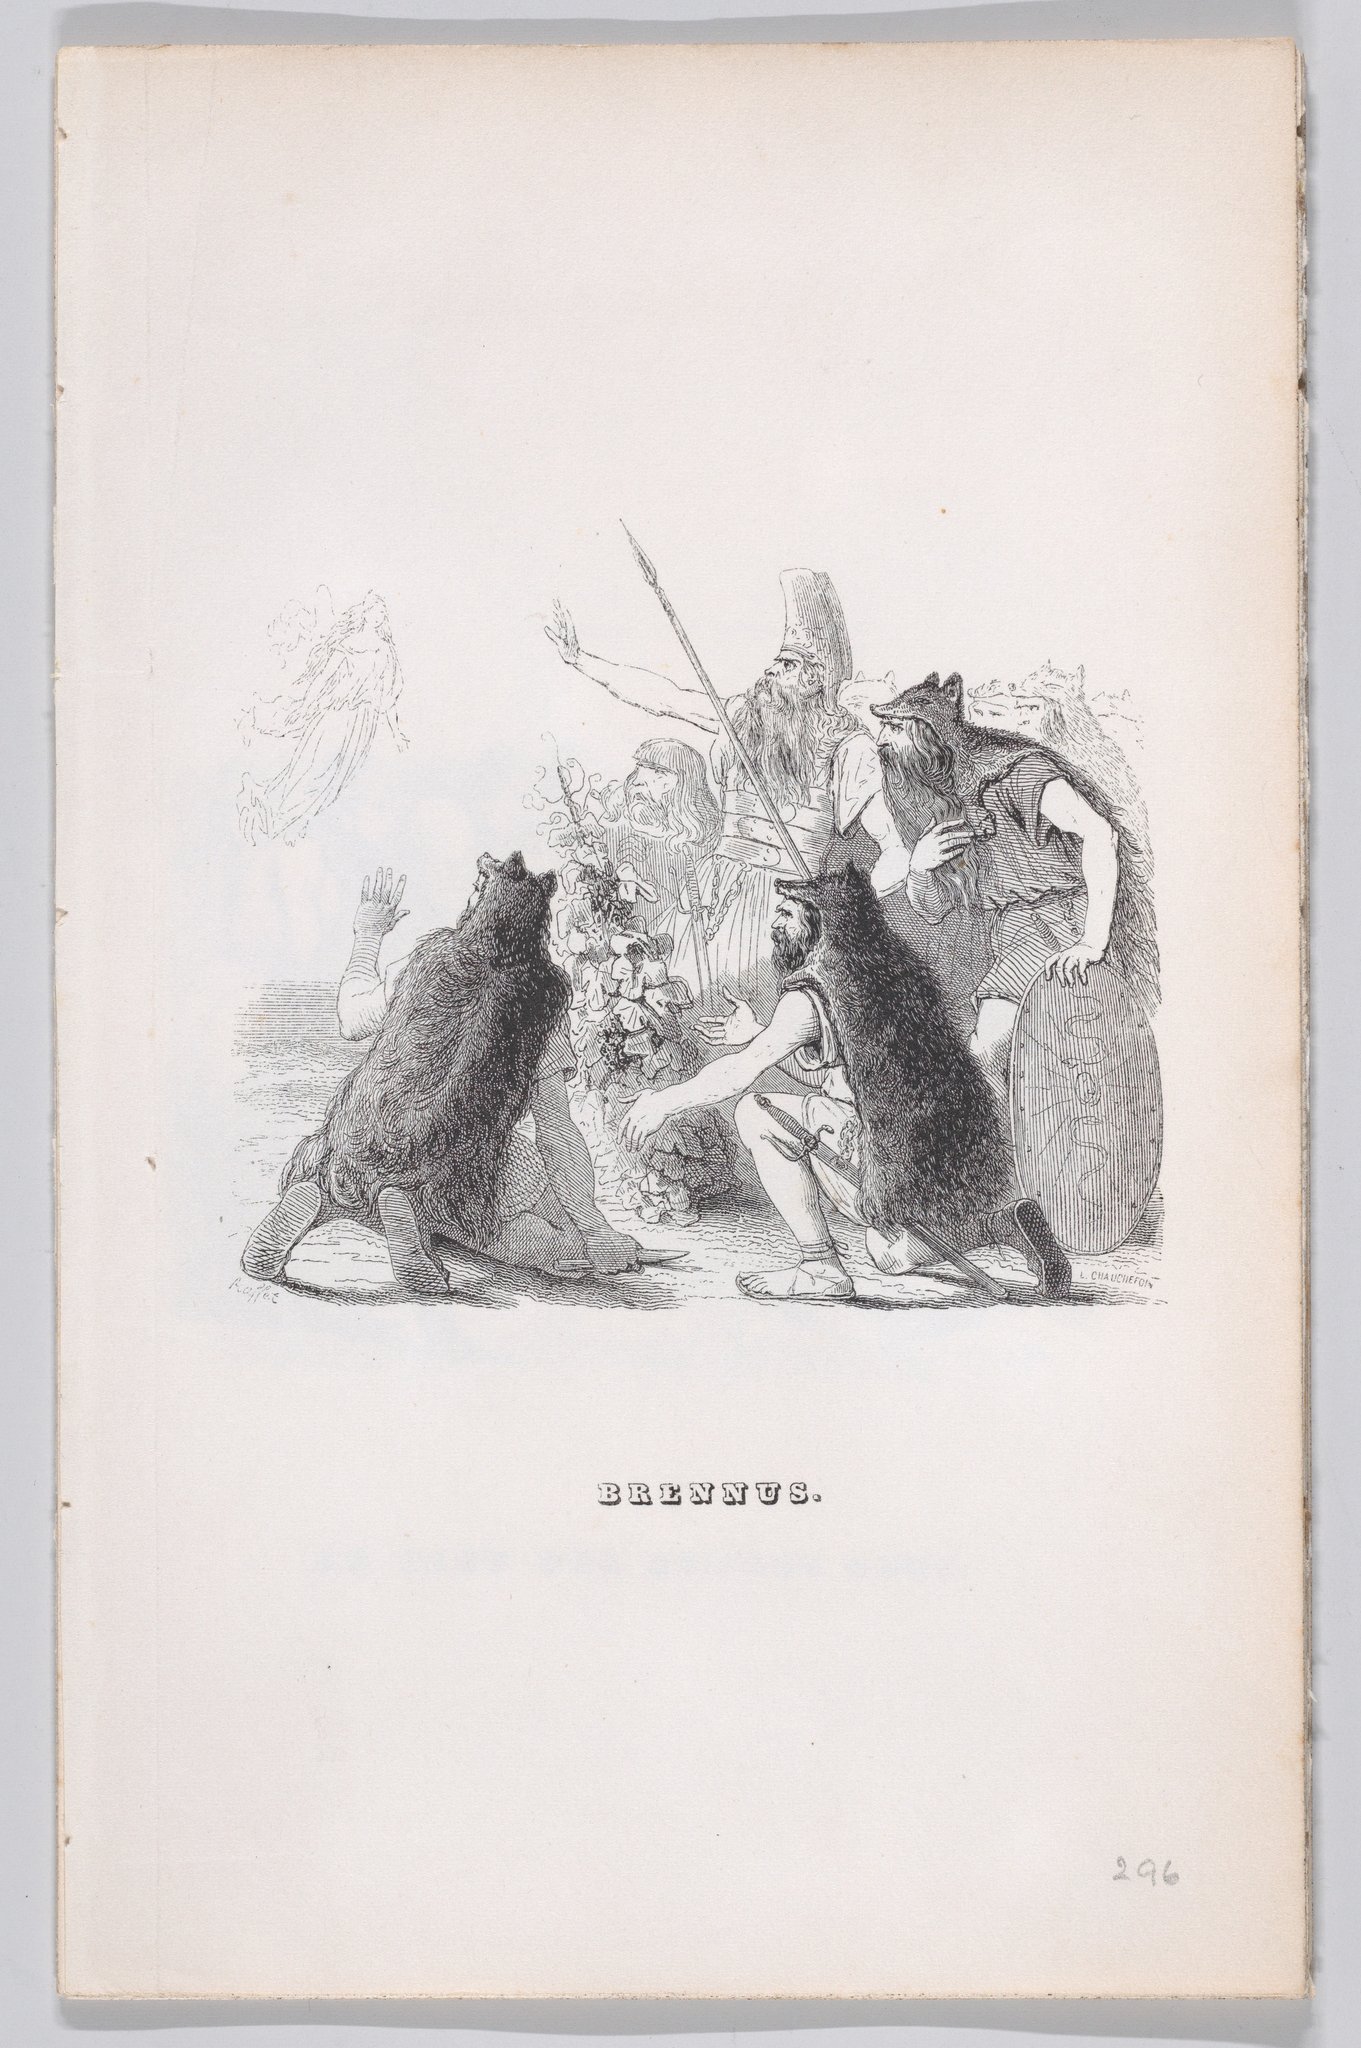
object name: print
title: Brennus, from "The Complete Works of Béranger"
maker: j. j. grandville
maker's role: illustrator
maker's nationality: french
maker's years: 1803-1847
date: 1836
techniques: engraving